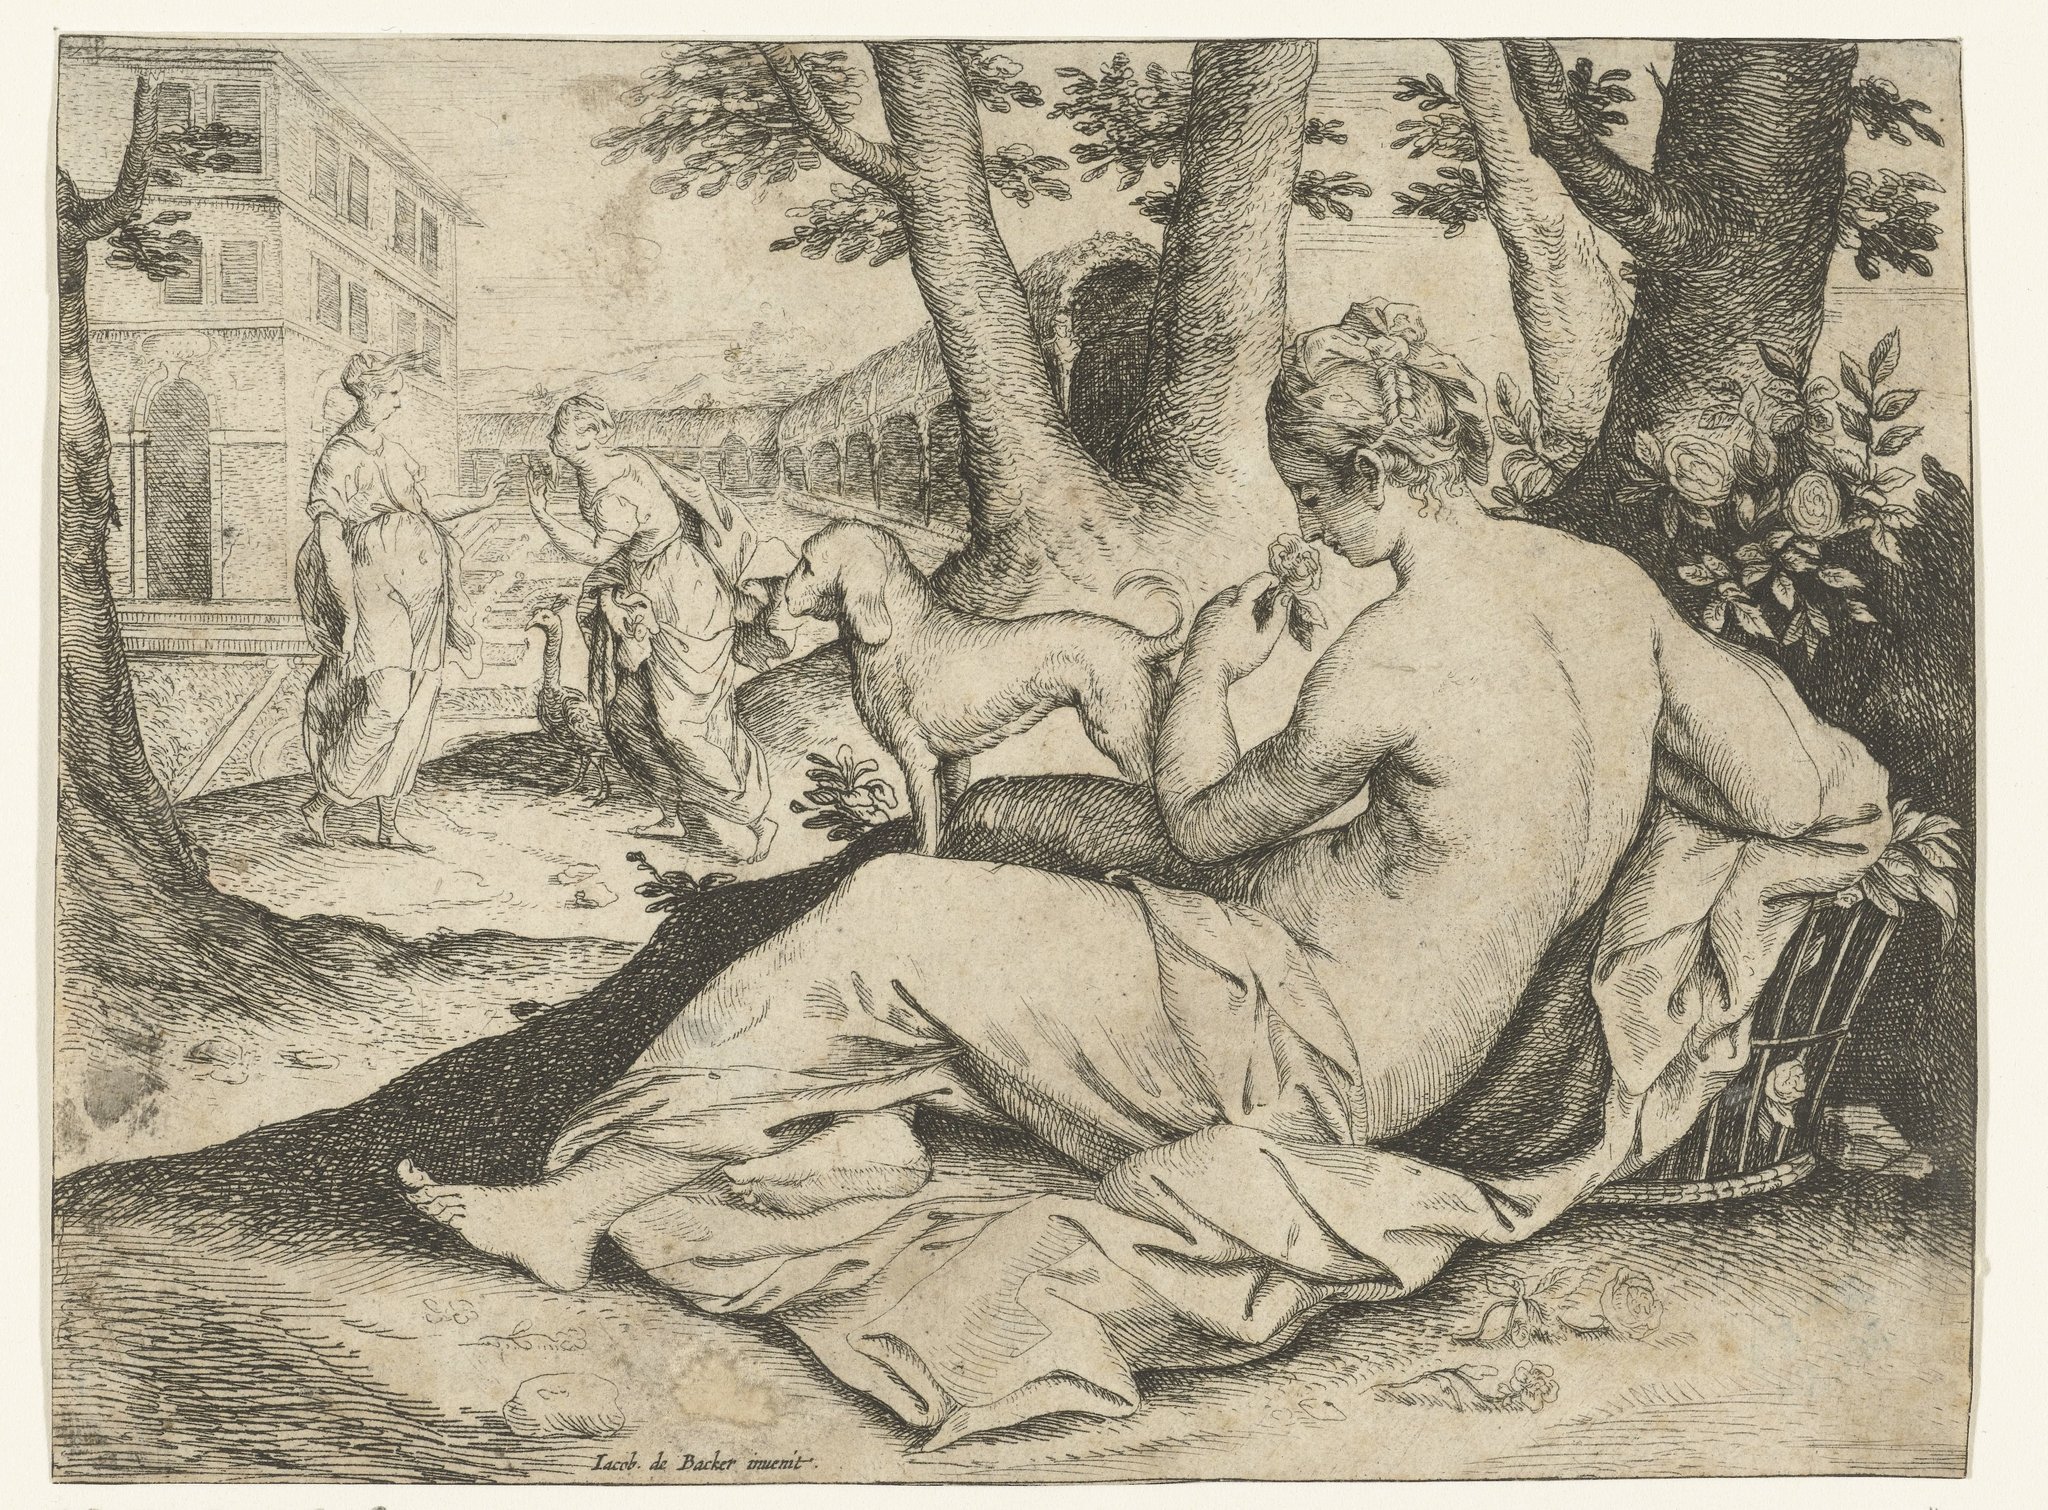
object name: print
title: Reuk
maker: jacob de backer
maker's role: print maker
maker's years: 1560-1600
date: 1570-1590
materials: paper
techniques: etching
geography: antwerp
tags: smell, smelling (one of the five senses)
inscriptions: collector's mark: Lugt 514, collector's mark: Lugt 2165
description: Een halfnaakte dame ligt in een tuin en ruikt aan een roos. Naast haar staat een hond. Prent uit een serie met vijf allegorische voorstellingen van de zintuigen.